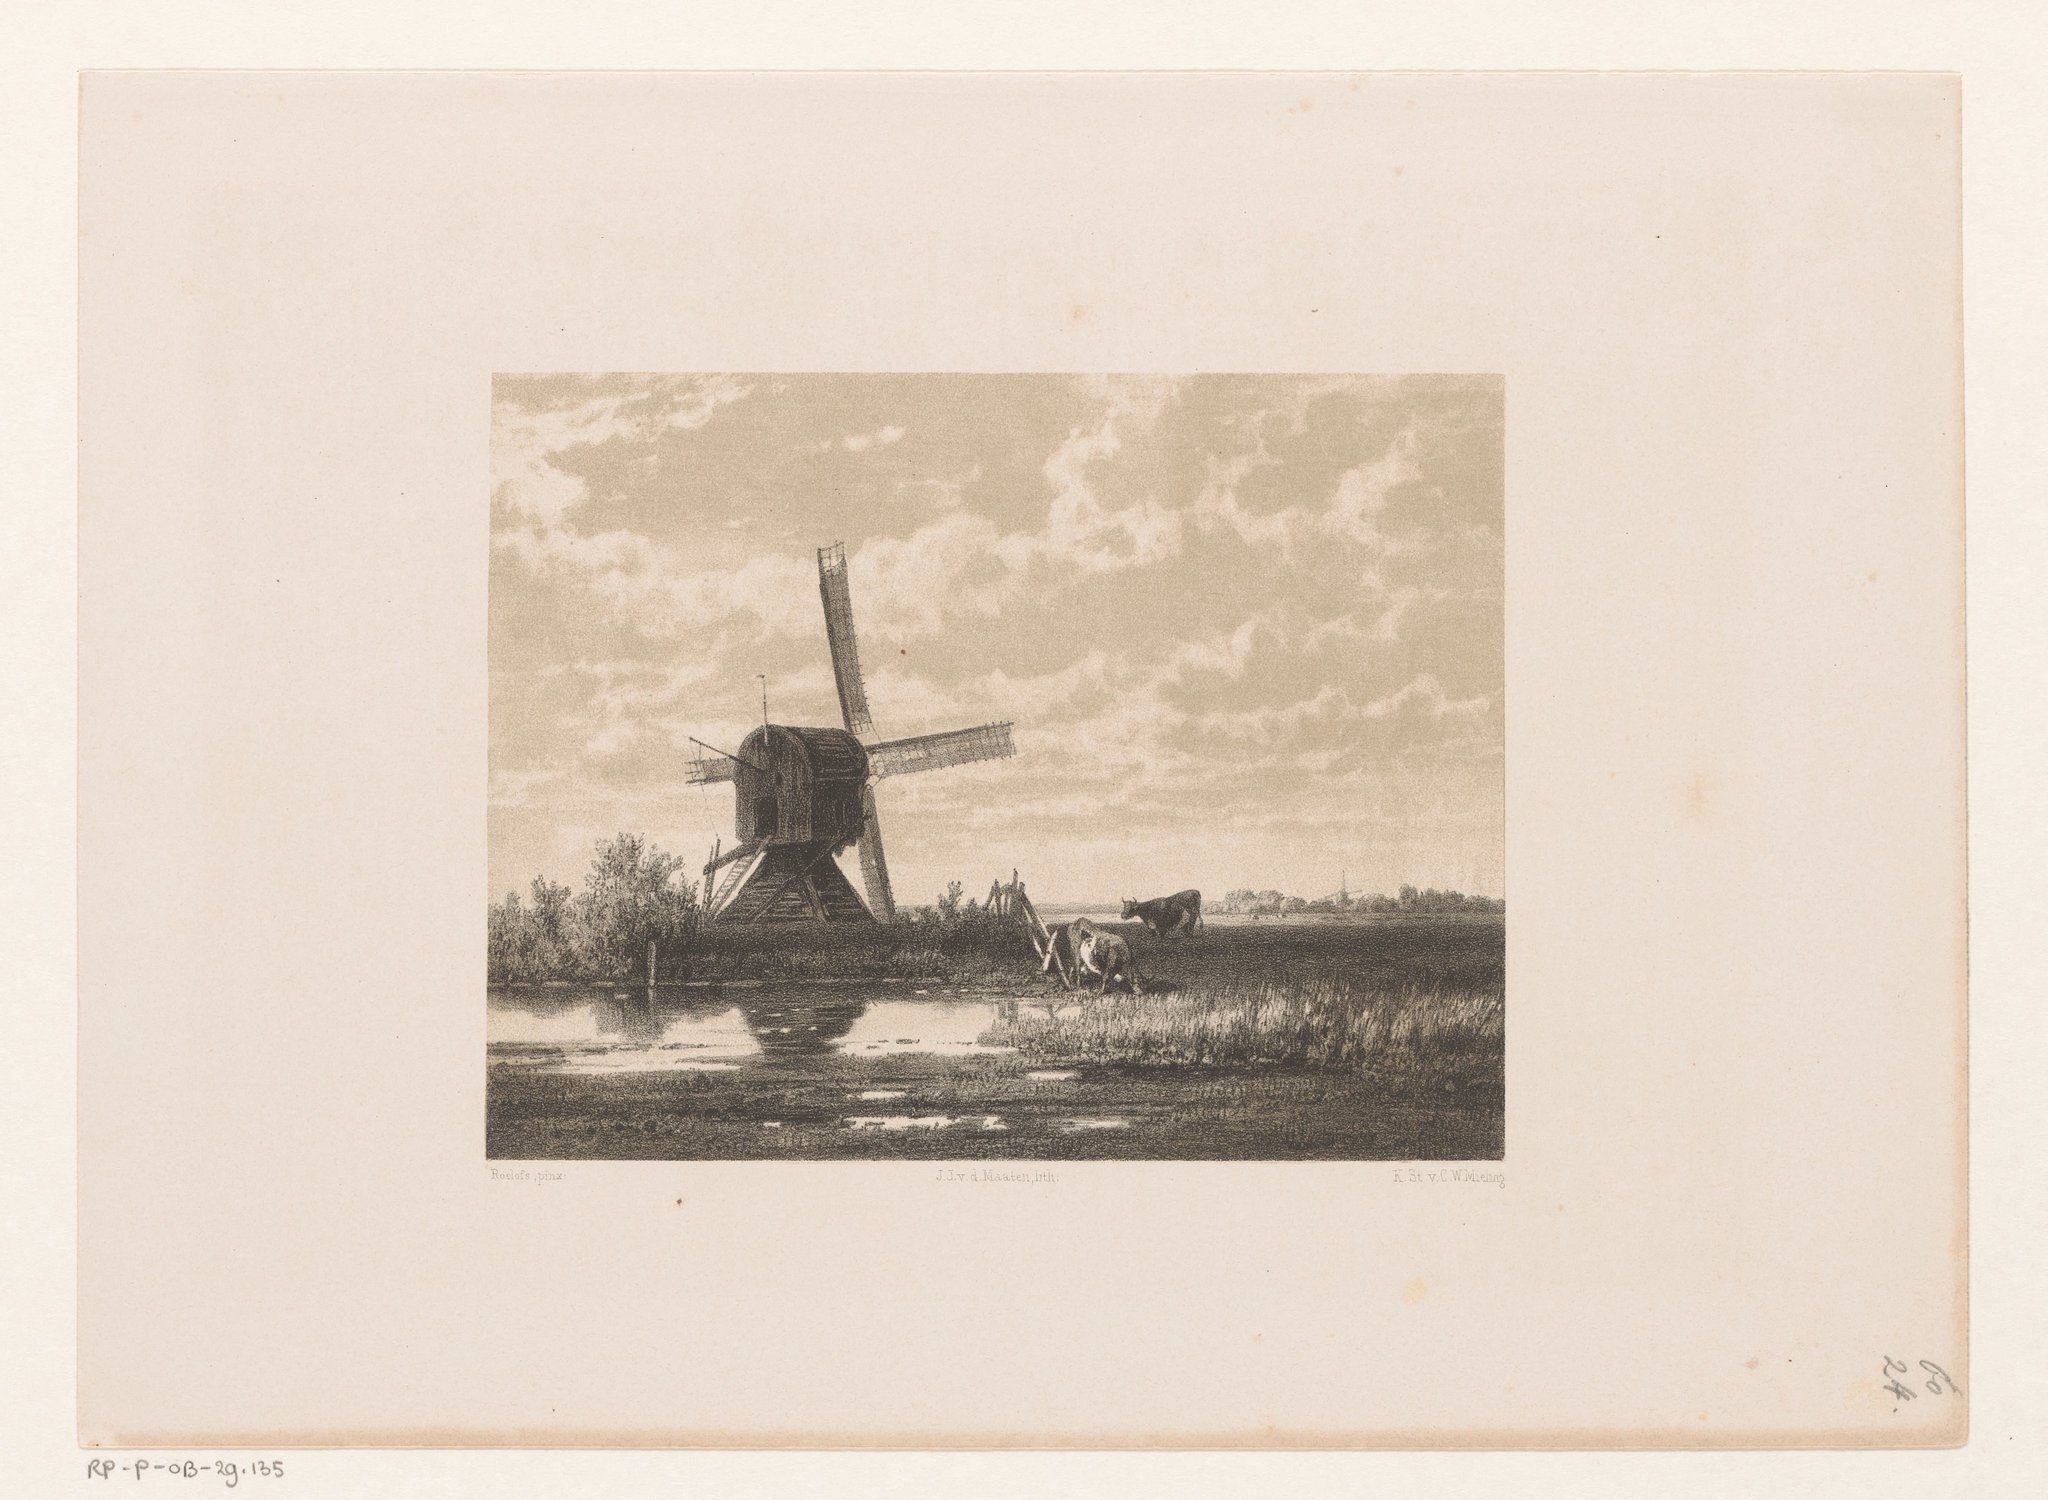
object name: print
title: Landschap met molen aan het water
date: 1830-1865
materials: paper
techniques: tone lithography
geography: the hague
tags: cow, meadow, pasture, windmill in landscape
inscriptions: collector's mark: Lugt 2228